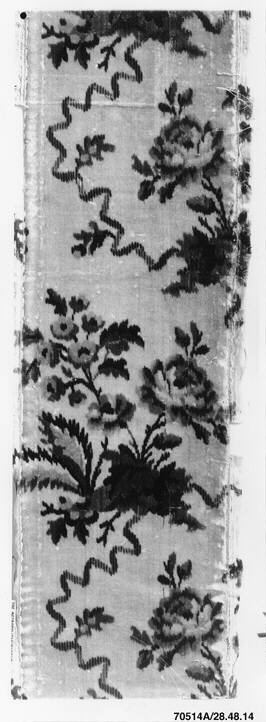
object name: fragment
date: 1767-1800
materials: silk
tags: flowers,leaves